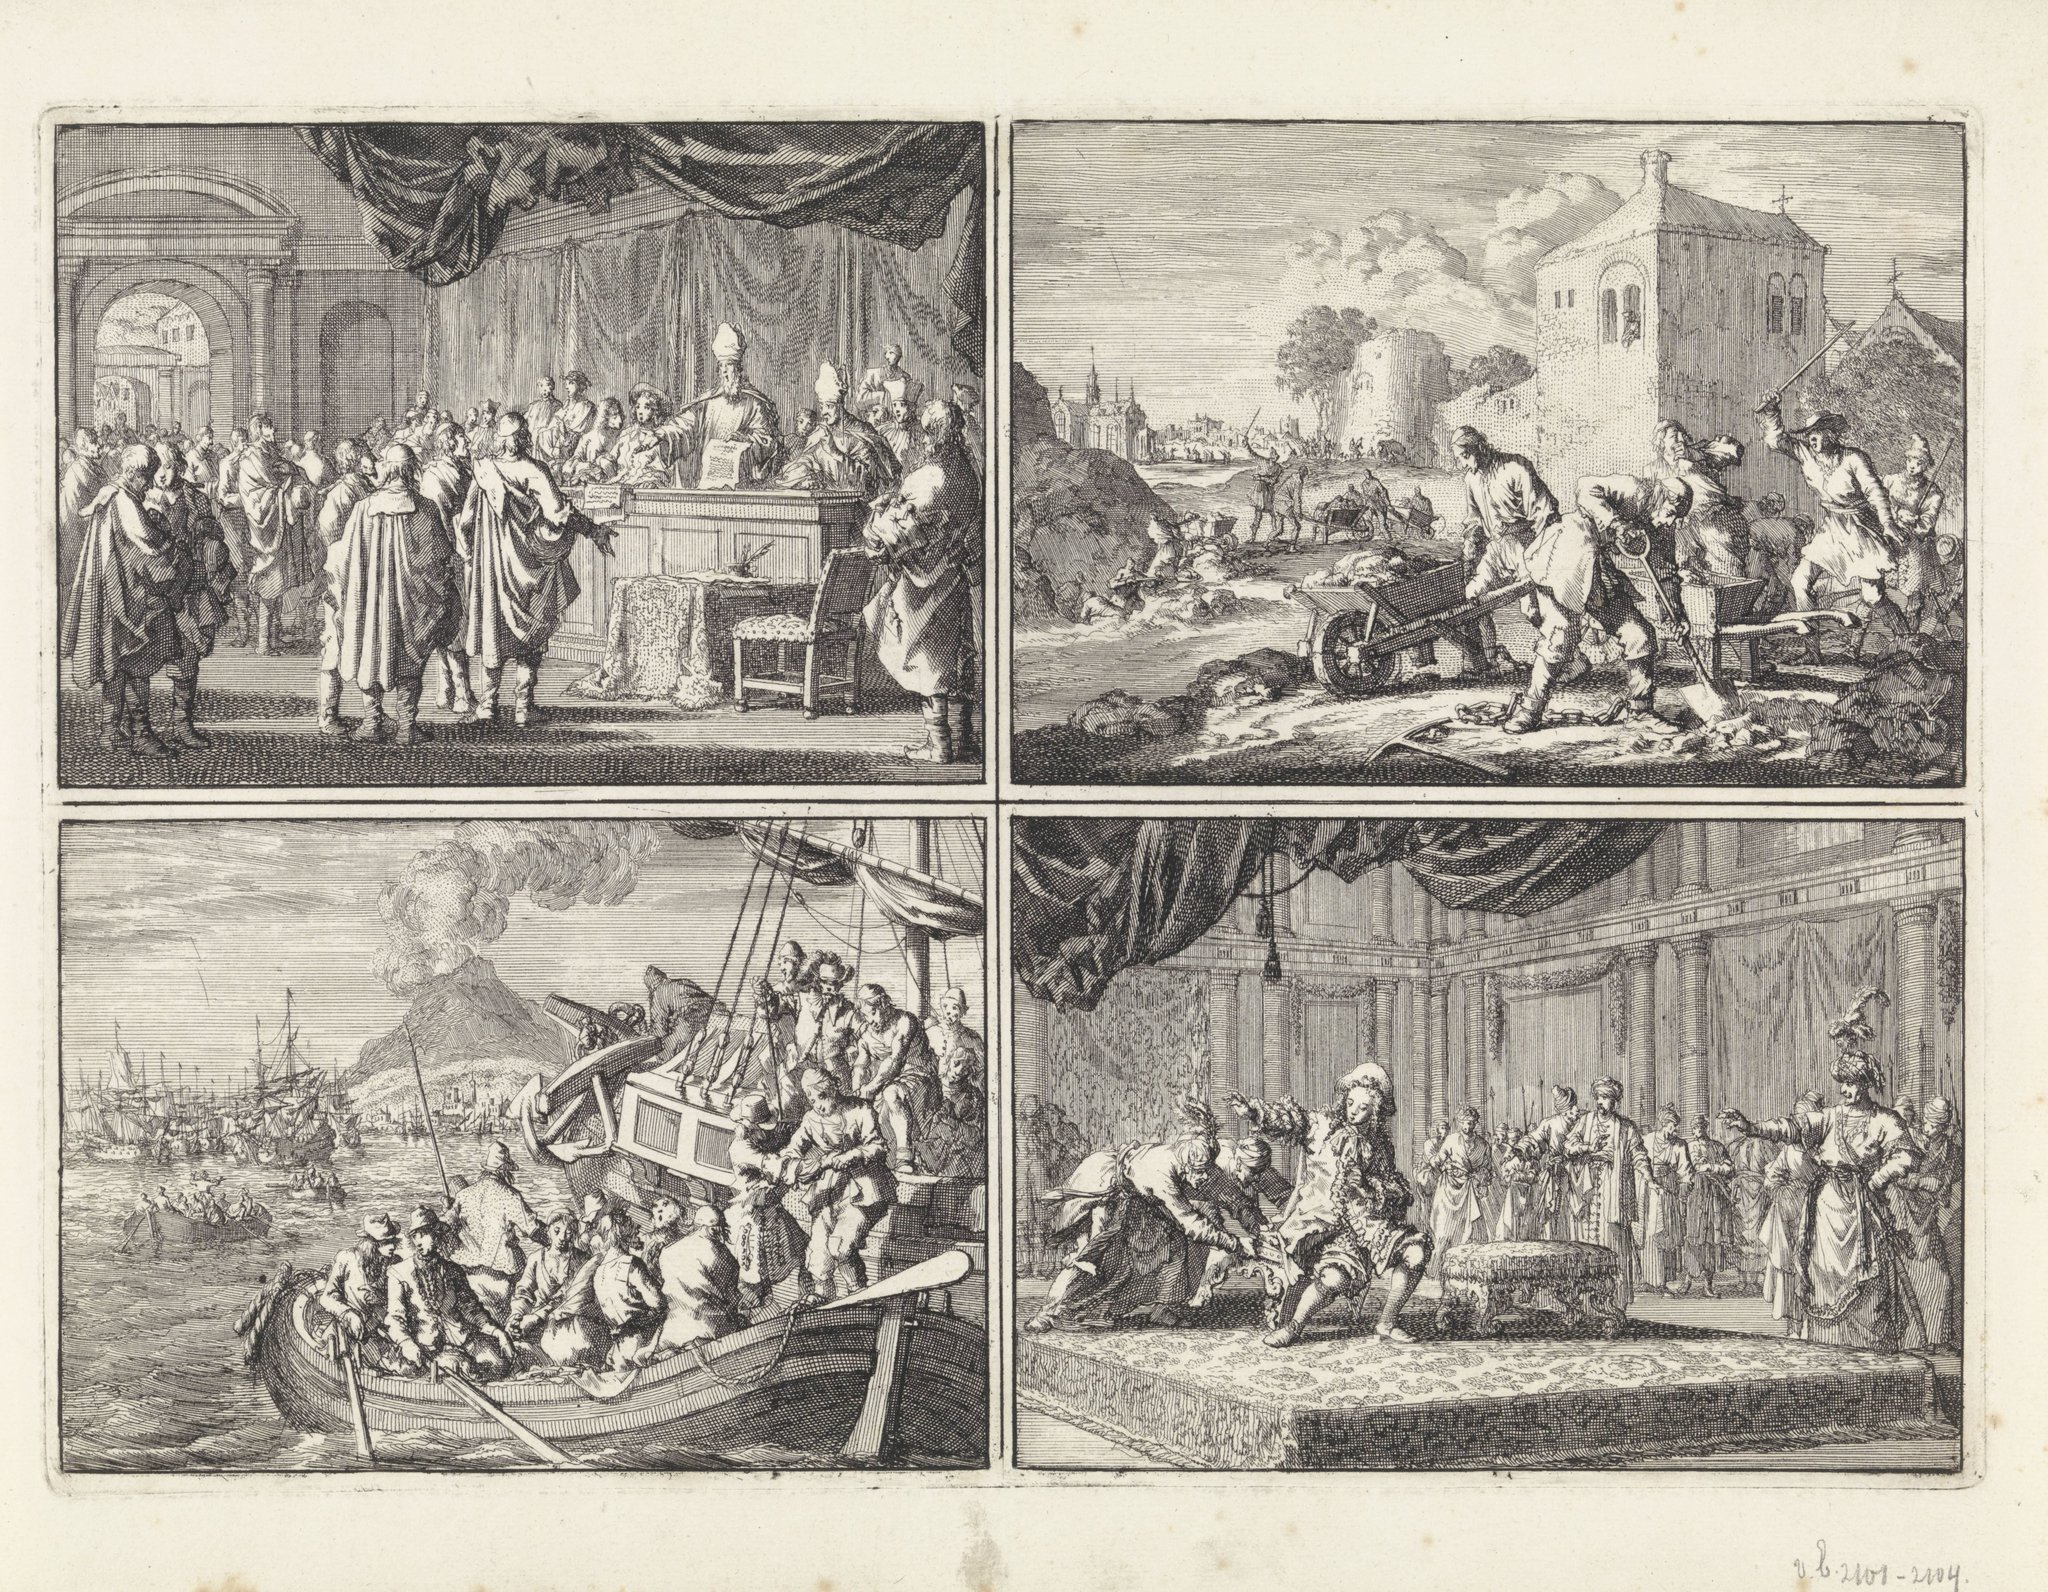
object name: print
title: Hervormden in Hongarije voor een rechtbank van bisschoppen en andere Roomsgezinden, 1670 / Hervormde predikanten in Hongarije veroordeeld tot zware arbeid, 1674 / Hervormde Hongaarse predikanten worden nabij Napels door Michiel Adriaenszoon de Ruyter verlost, 1676 / Aan de Franse gezant te Constantinopel wordt de zetel ontrukt die hij had geplaatst naast de zetel van de groot-vizier, 1677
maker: jan luyken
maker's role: draughtsman, print maker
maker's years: 1649-1712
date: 1698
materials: paper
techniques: etching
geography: amsterdam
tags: flushing, michiel adriaenszoon de ruyter, liberation (of an enslaved person) (+ variant), archbishop, bishop, etc. (roman catholic), slavery; serfs and enslaved persons, stool, ambassador, audition; ruler giving audience, court session (court of justice), workhouse, penal camp, penitentiary, chain gang, persecution of believers, trireme, galley, naples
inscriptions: collector's mark: Lugt 2228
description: Prenten gebruikt als illustratie in: Gottfried, Johann Ludwig. Historische kronyck; vervattende een (...) beschrijvingh der aldergedenckwaerdigste geschiedenissen des weerelds, van den aenvangh der scheppingh tot (...) 1576 (2 delen). Leiden: Pieter van der Aa, 1698, dl. II, p. 1035, 1037, 1039, 1049.